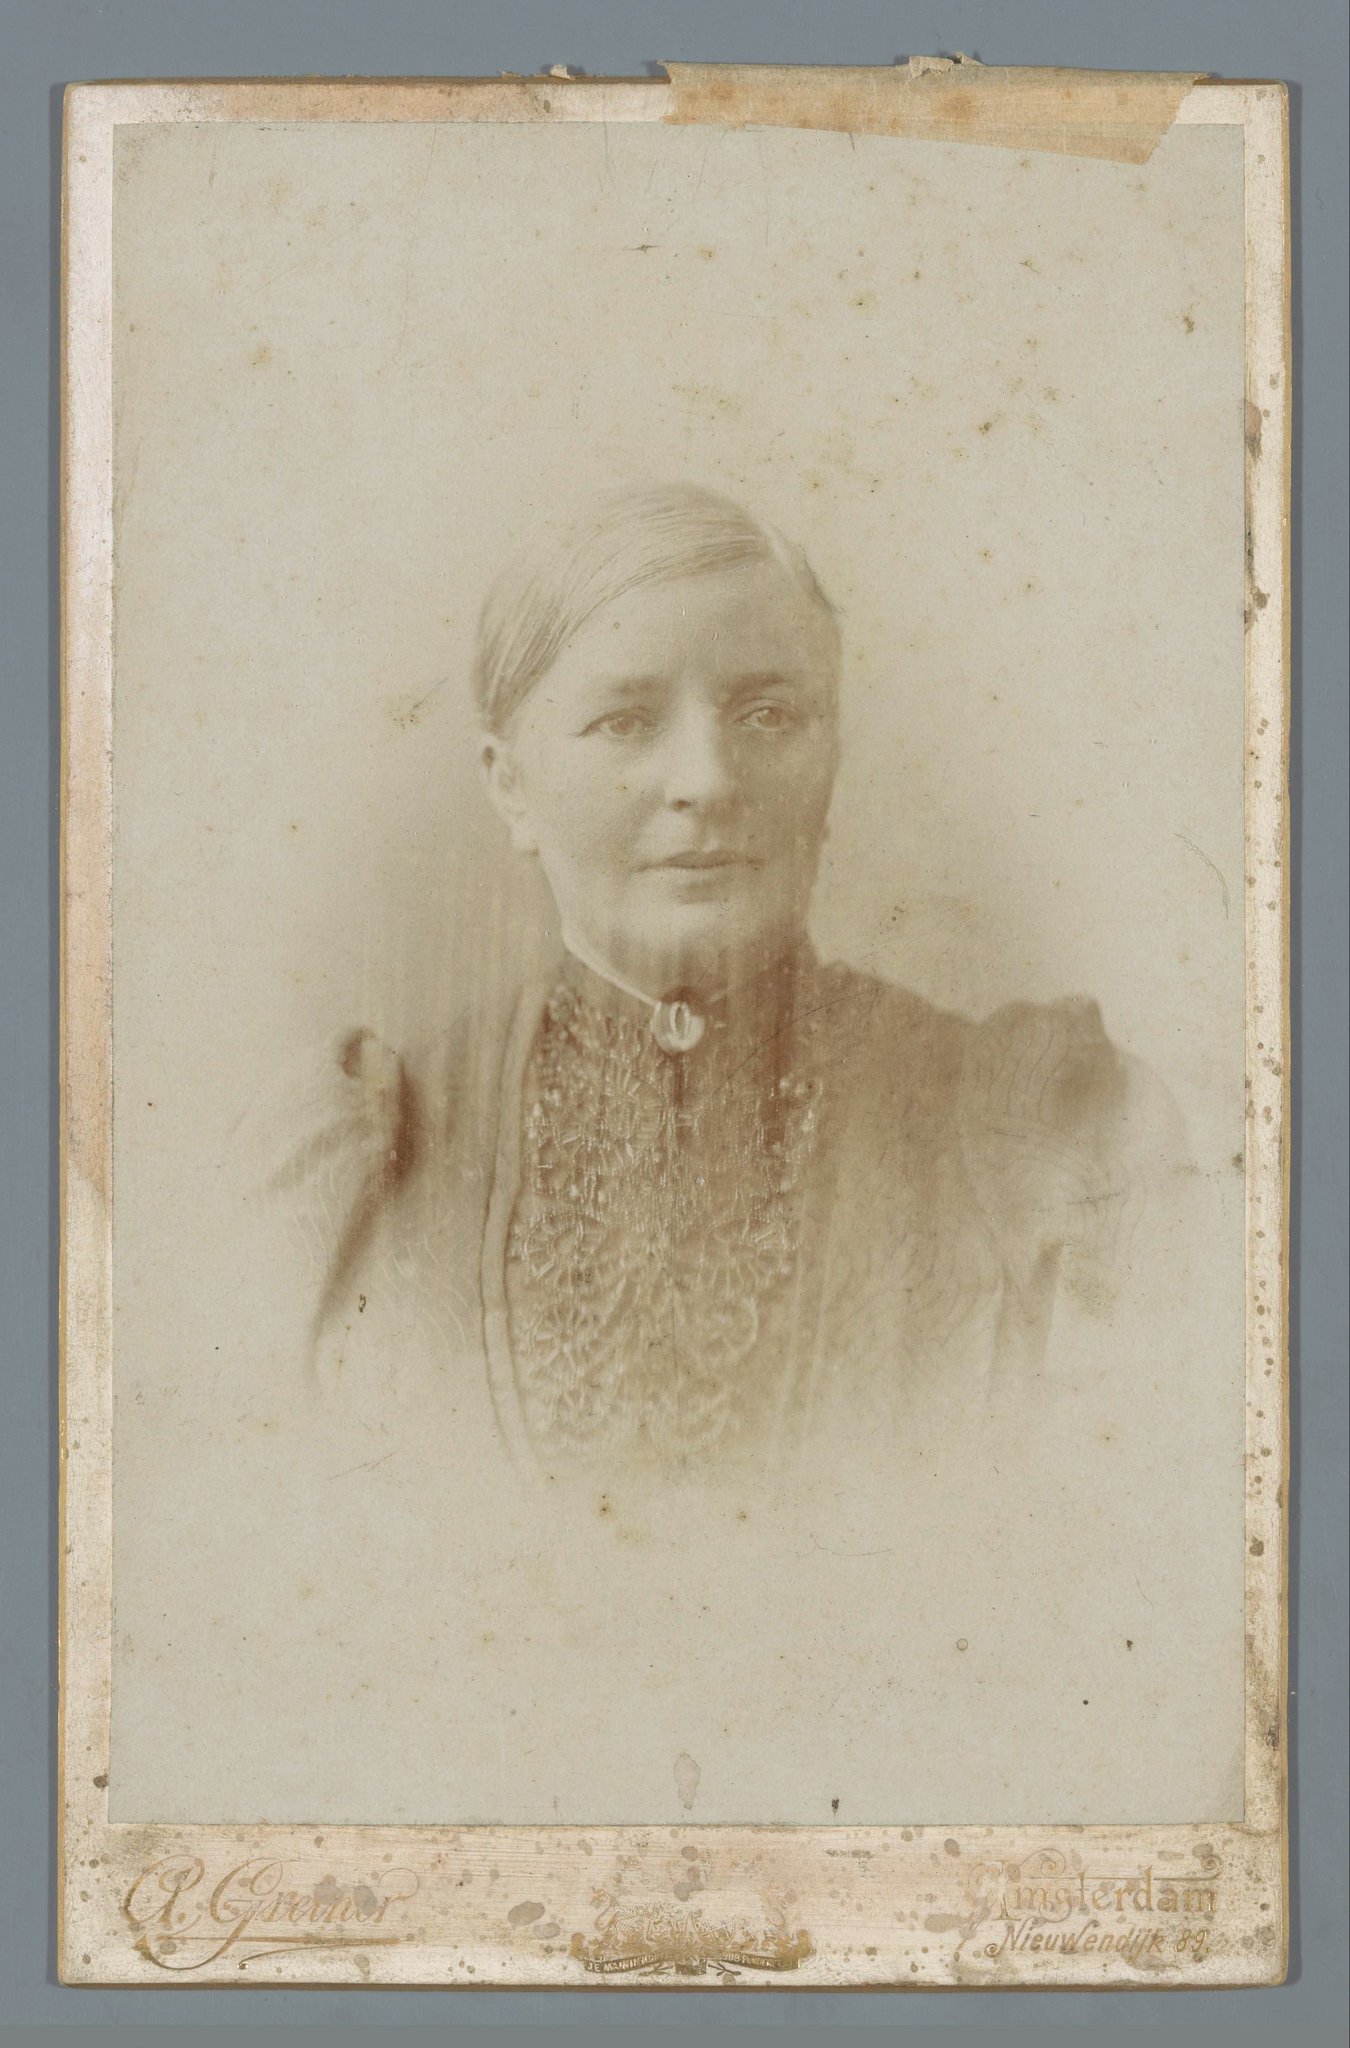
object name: cabinet photograph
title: Portret van een onbekende vrouw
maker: albert greiner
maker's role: fotograaf, fotostudio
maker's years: 1833-1890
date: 1861-1890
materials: cardboard, photographic support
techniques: collodion silver print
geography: amsterdam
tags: adult woman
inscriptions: name: ‘Albert Greiner Photograaf van wijlen Z.M. den Koning Willem III en H.M. de Koningin Weduwe Amsterdam Nieuwendijk 89. (...)’